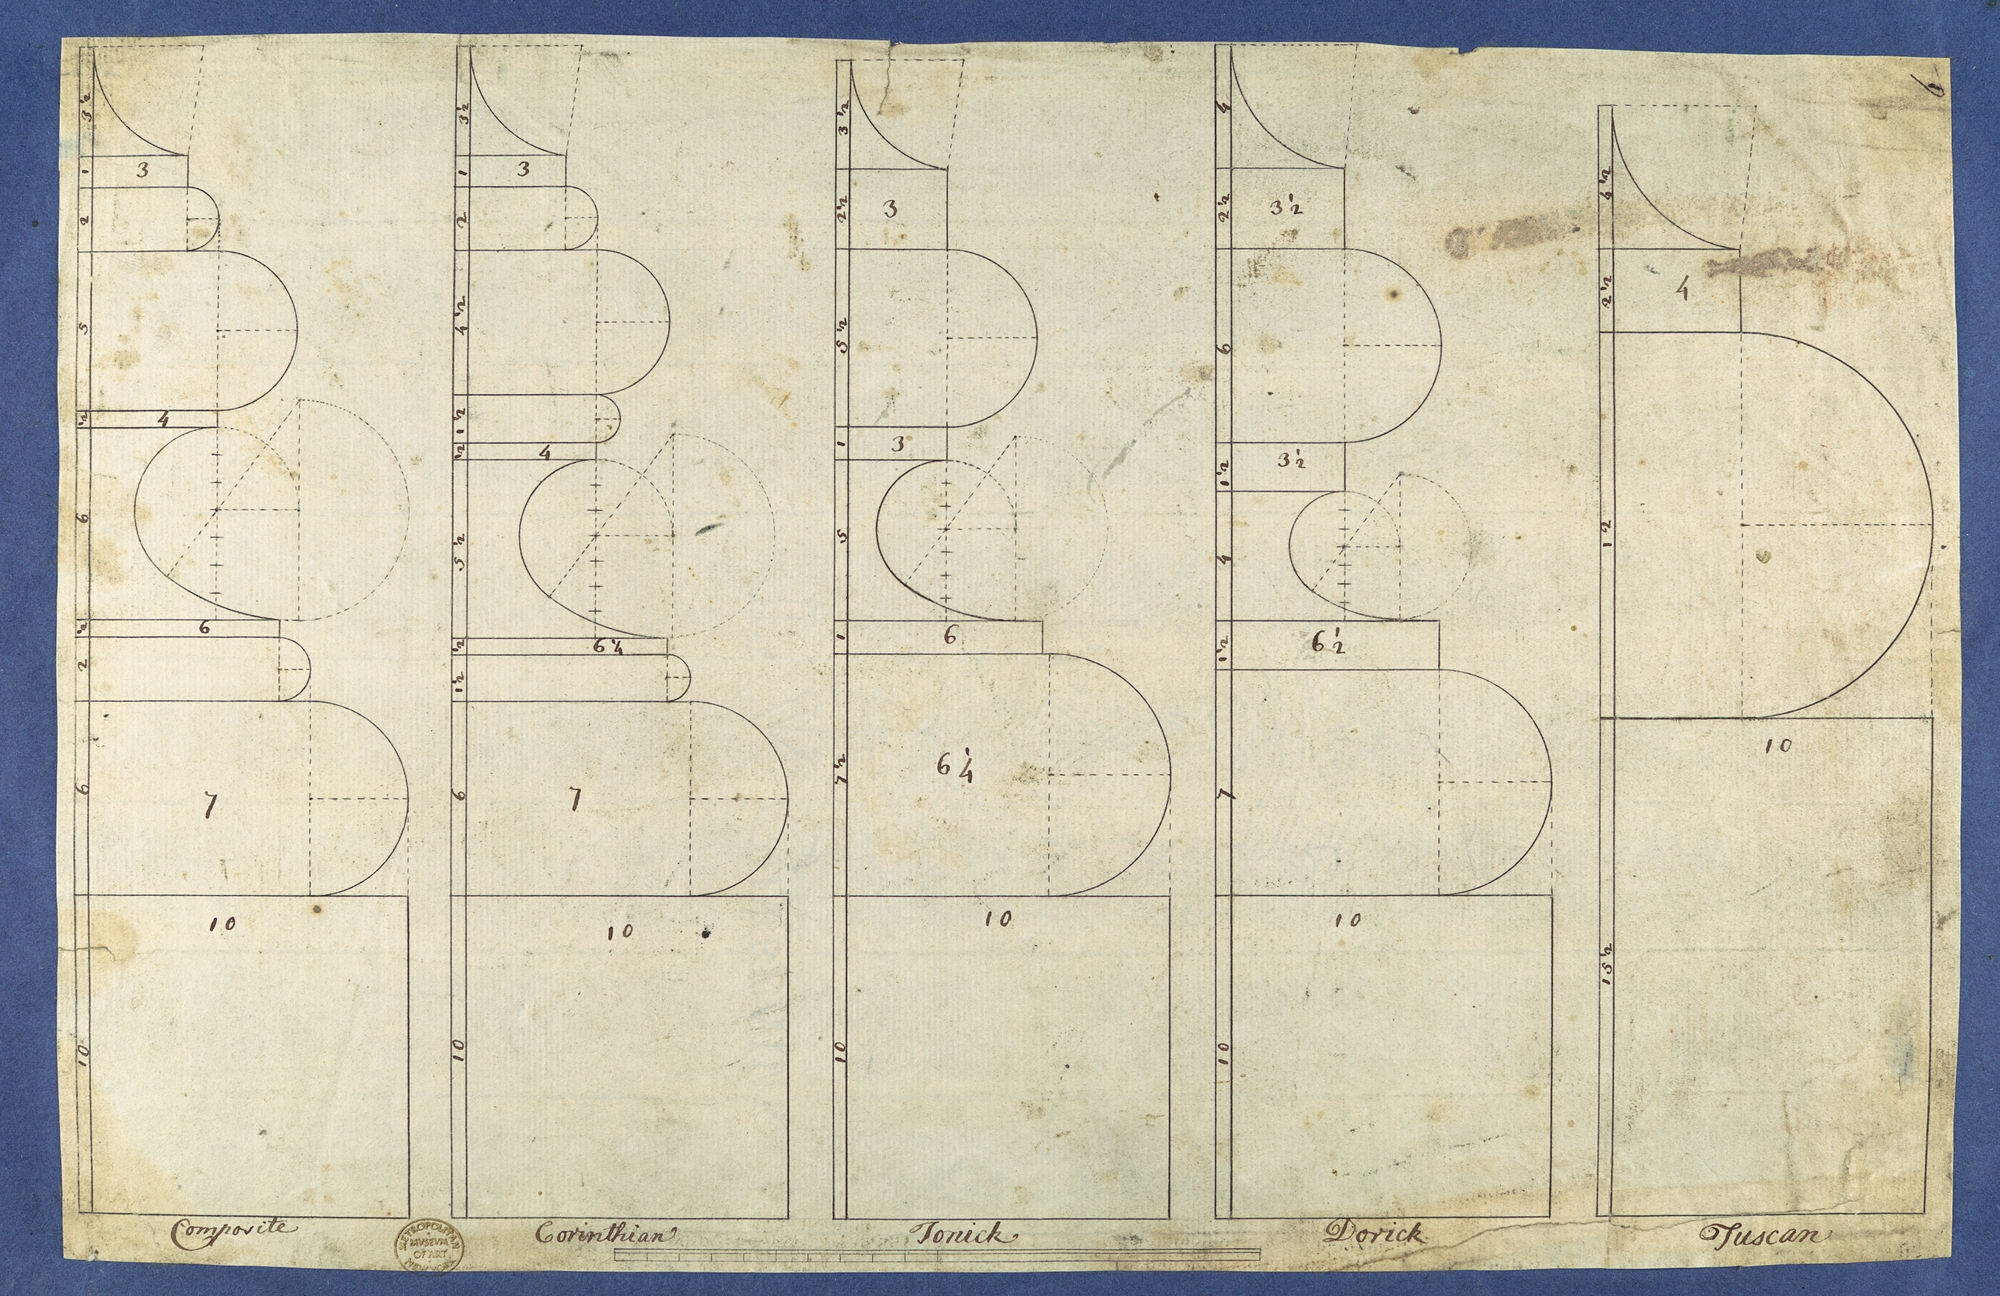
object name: drawing ornament architecture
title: The Bases of the Columns, in Chippendale Drawings, Vol. I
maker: thomas chippendale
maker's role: artist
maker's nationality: british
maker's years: 1718-1779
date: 1753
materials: ink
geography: london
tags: architecture